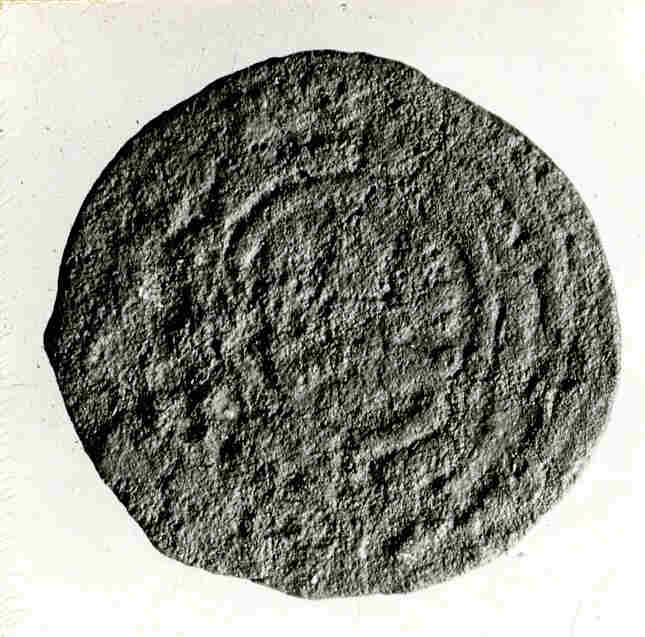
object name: coin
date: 758-768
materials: copper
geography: iran